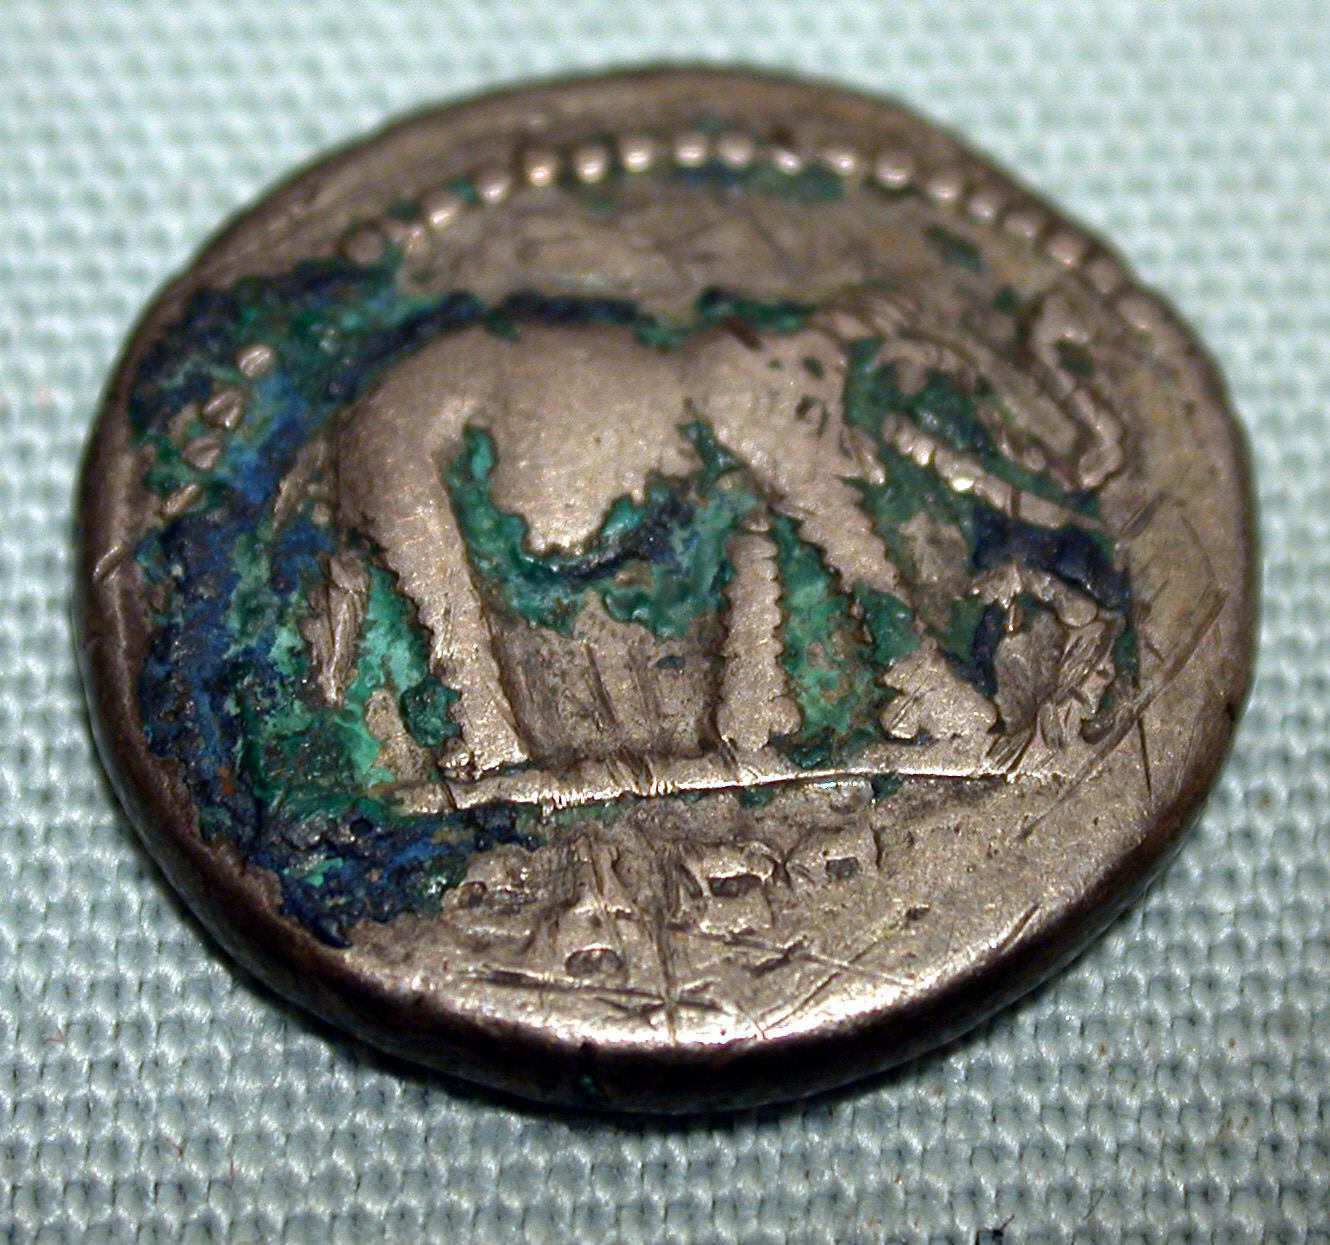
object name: denarius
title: Silver denarius of Julius Caesar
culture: roman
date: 49-48 BCE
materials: silver